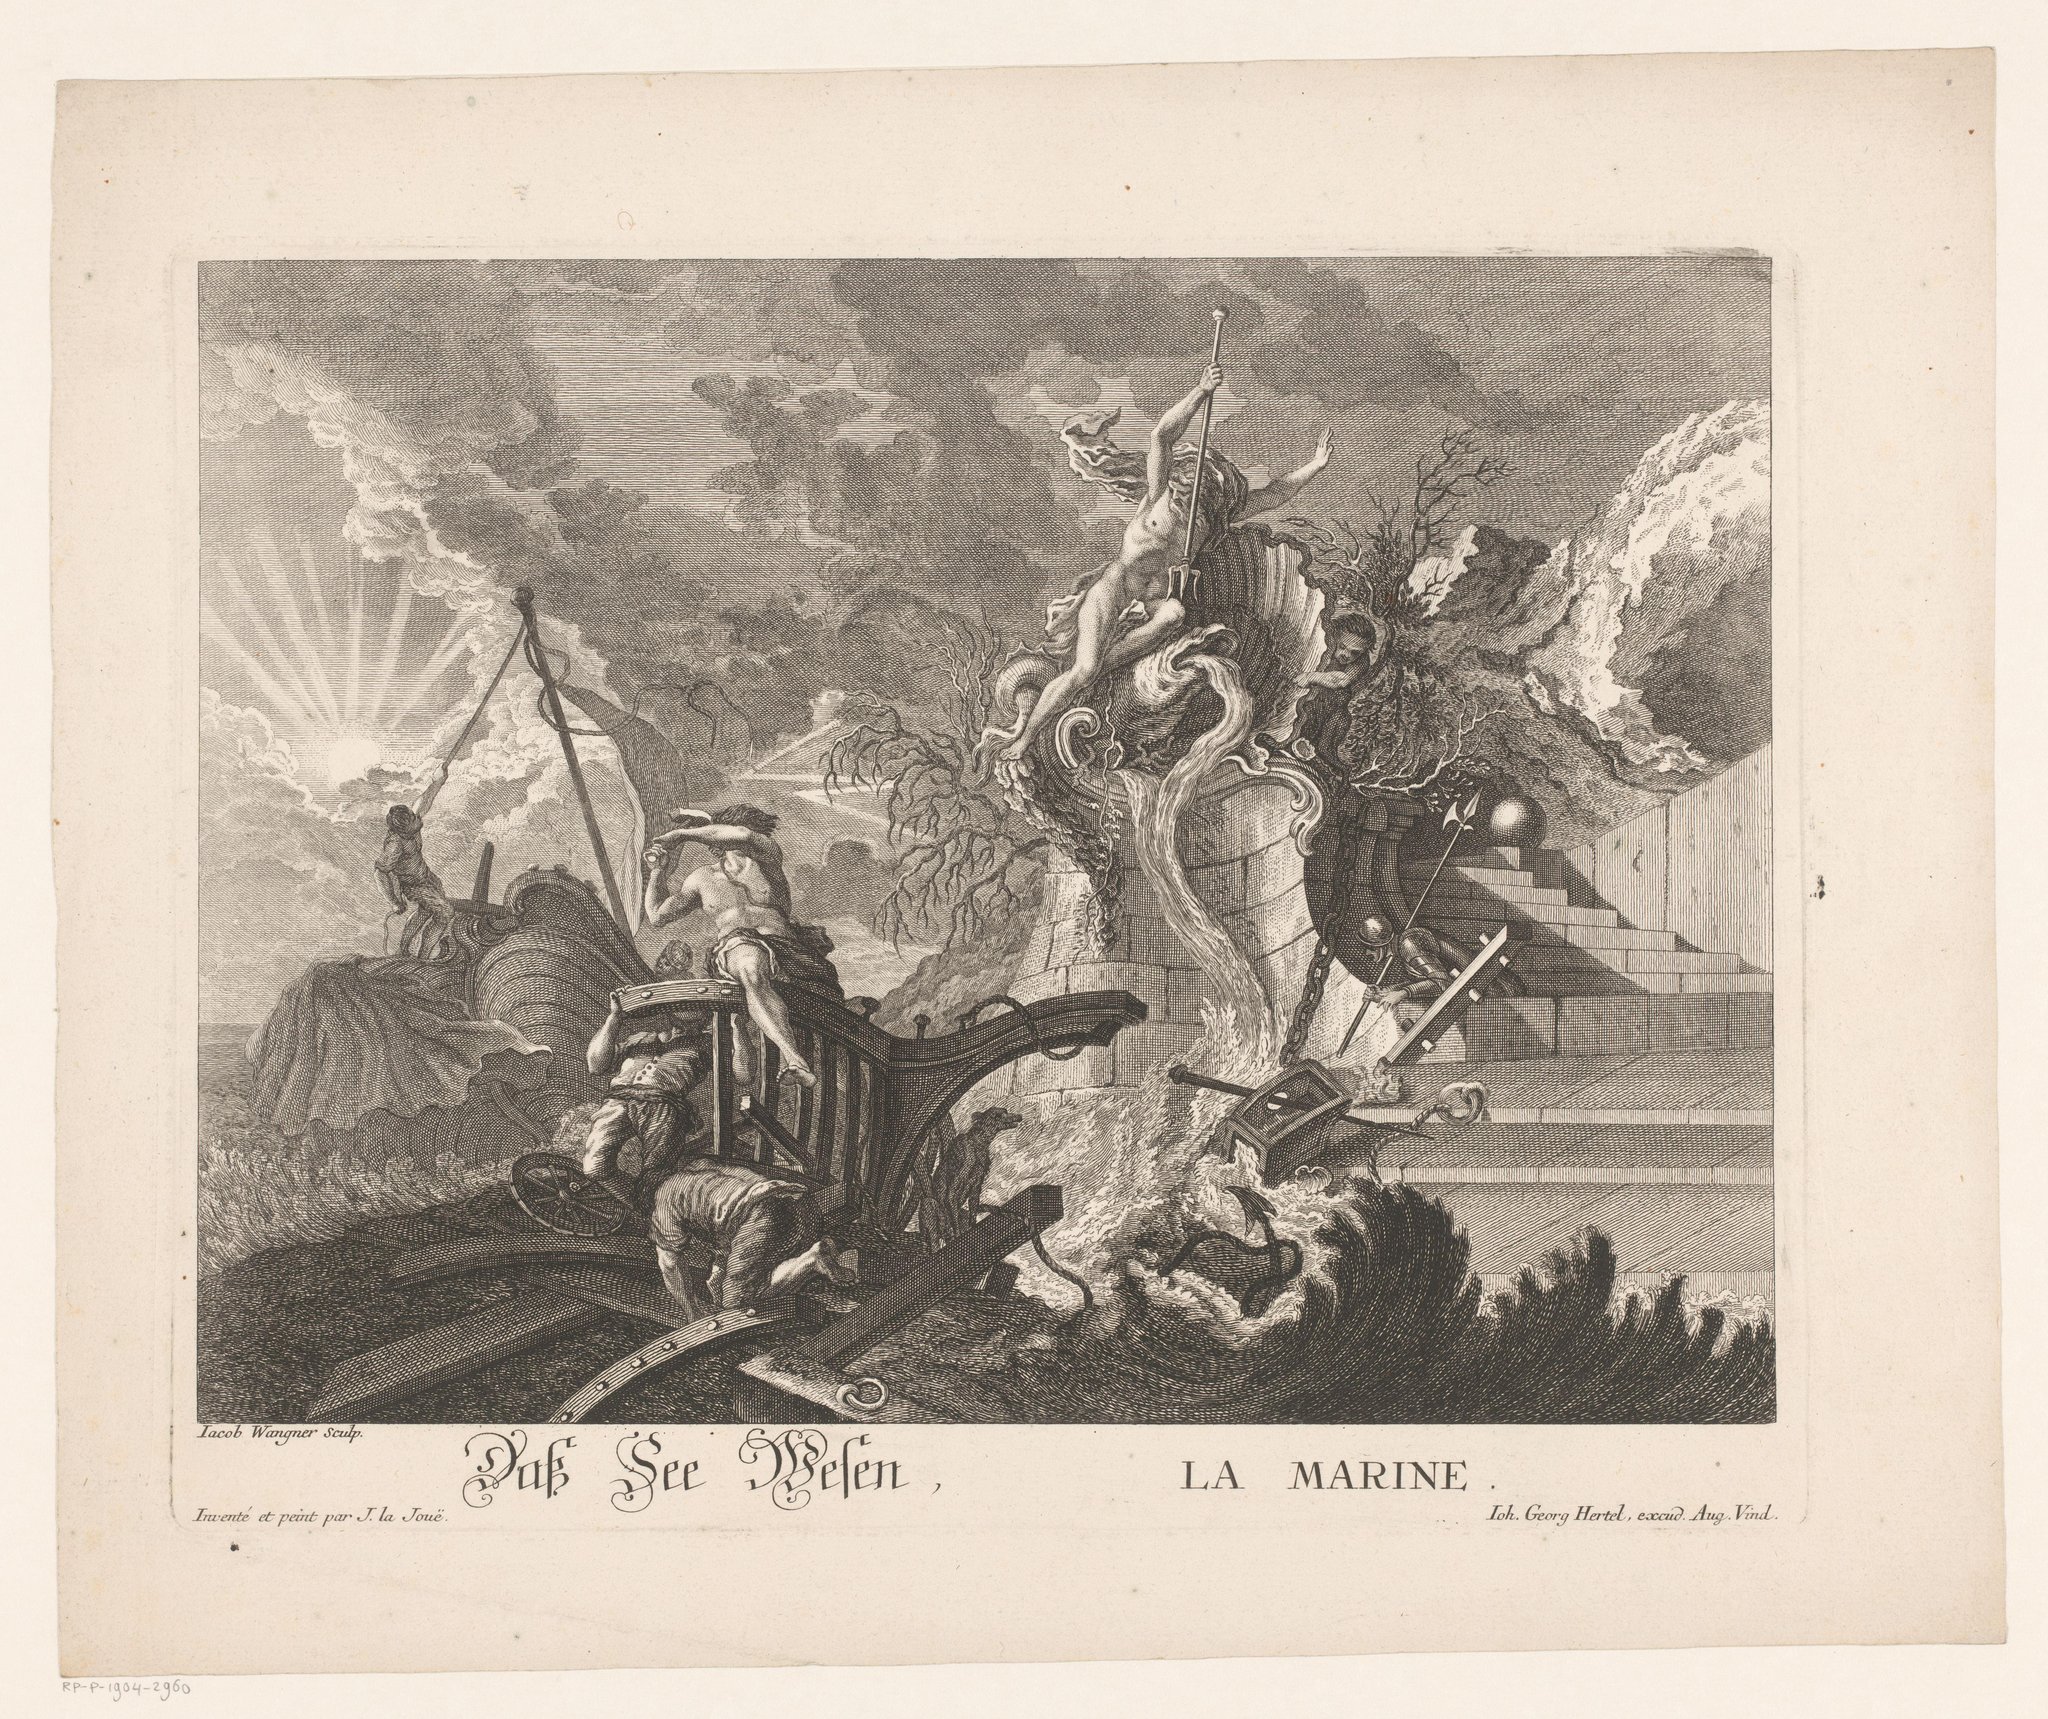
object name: print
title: Das See Wesen / La marine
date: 1729-1781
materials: paper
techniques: etching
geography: germany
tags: sailing-ship, sailing-boat, triton(s), building a ship, ship under construction, sea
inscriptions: collector's mark: Lugt 2228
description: Deze prent maakt deel uit van een serie bestaande uit ten minste drie prenten met allegorische voorstellingen.